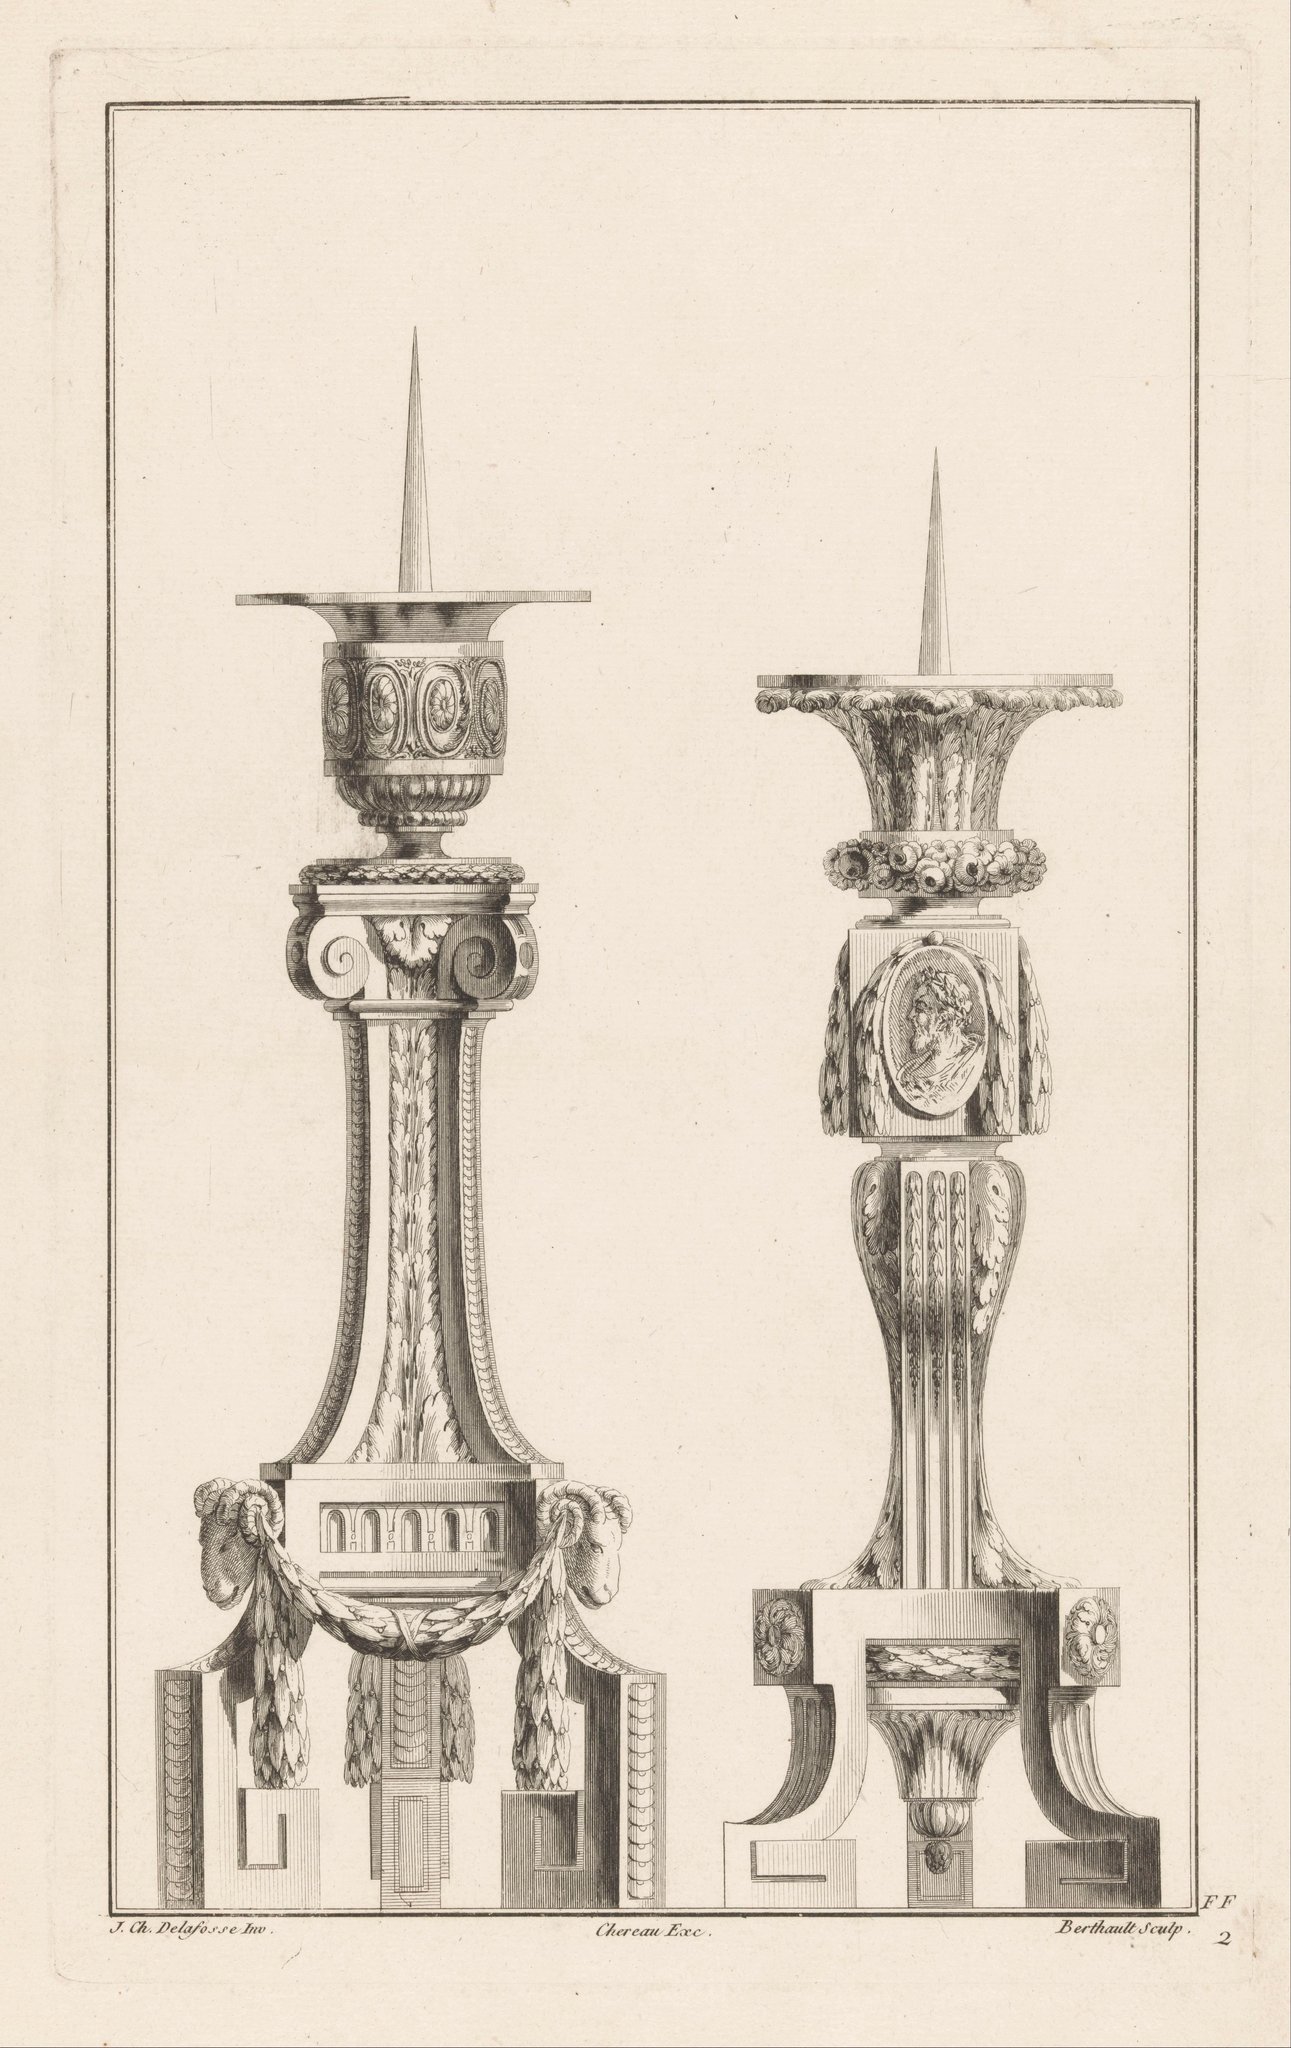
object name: ornament print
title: 30e Cahier FF Cahier de Chandeliers d'Eglise, Pieds de Croix &c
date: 1771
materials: paper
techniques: engraving, etching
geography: paris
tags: ram's head ~ ornament, chandelier, candelabrum, ornament ~ medallion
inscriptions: collector's mark: Lugt 2228, collector's mark: Lugt 2760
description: Twee geornamenteerde kandelaars, links met ramskoppen en een guirlande, rechts met blamotieven en een ovaal medaillon met mannenportret en profil.